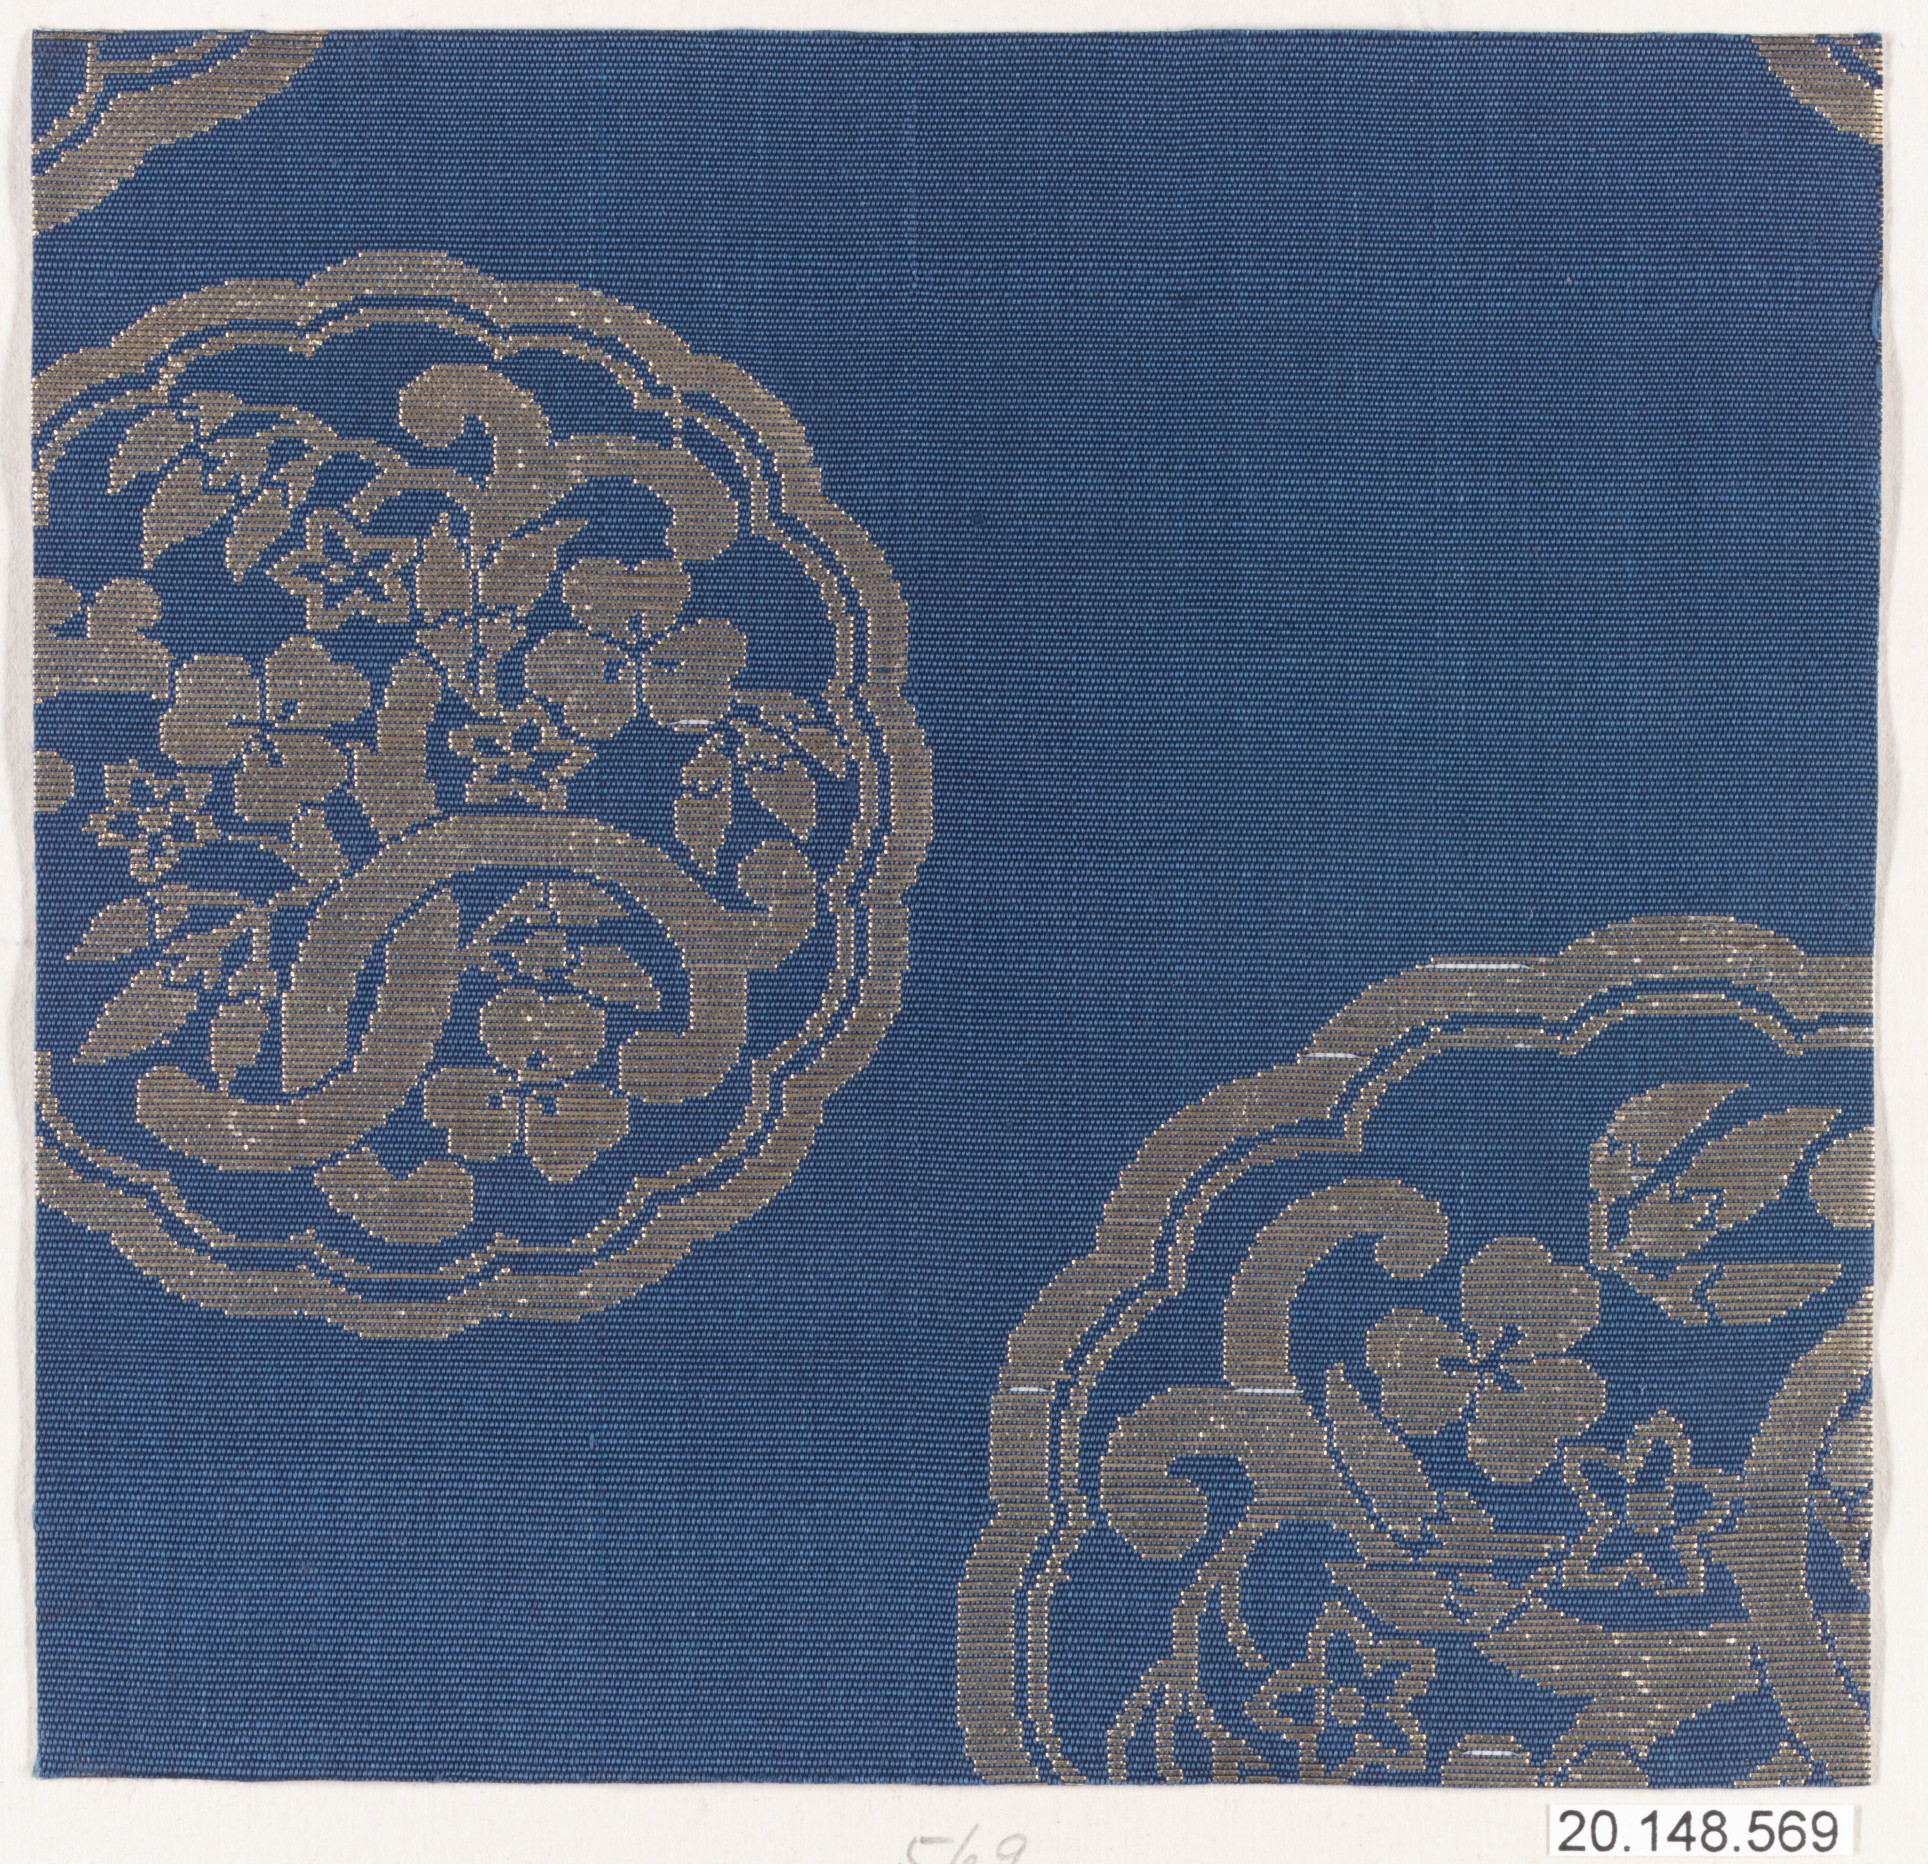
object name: piece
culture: japanese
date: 1701-1800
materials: silk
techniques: compound weave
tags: flowers